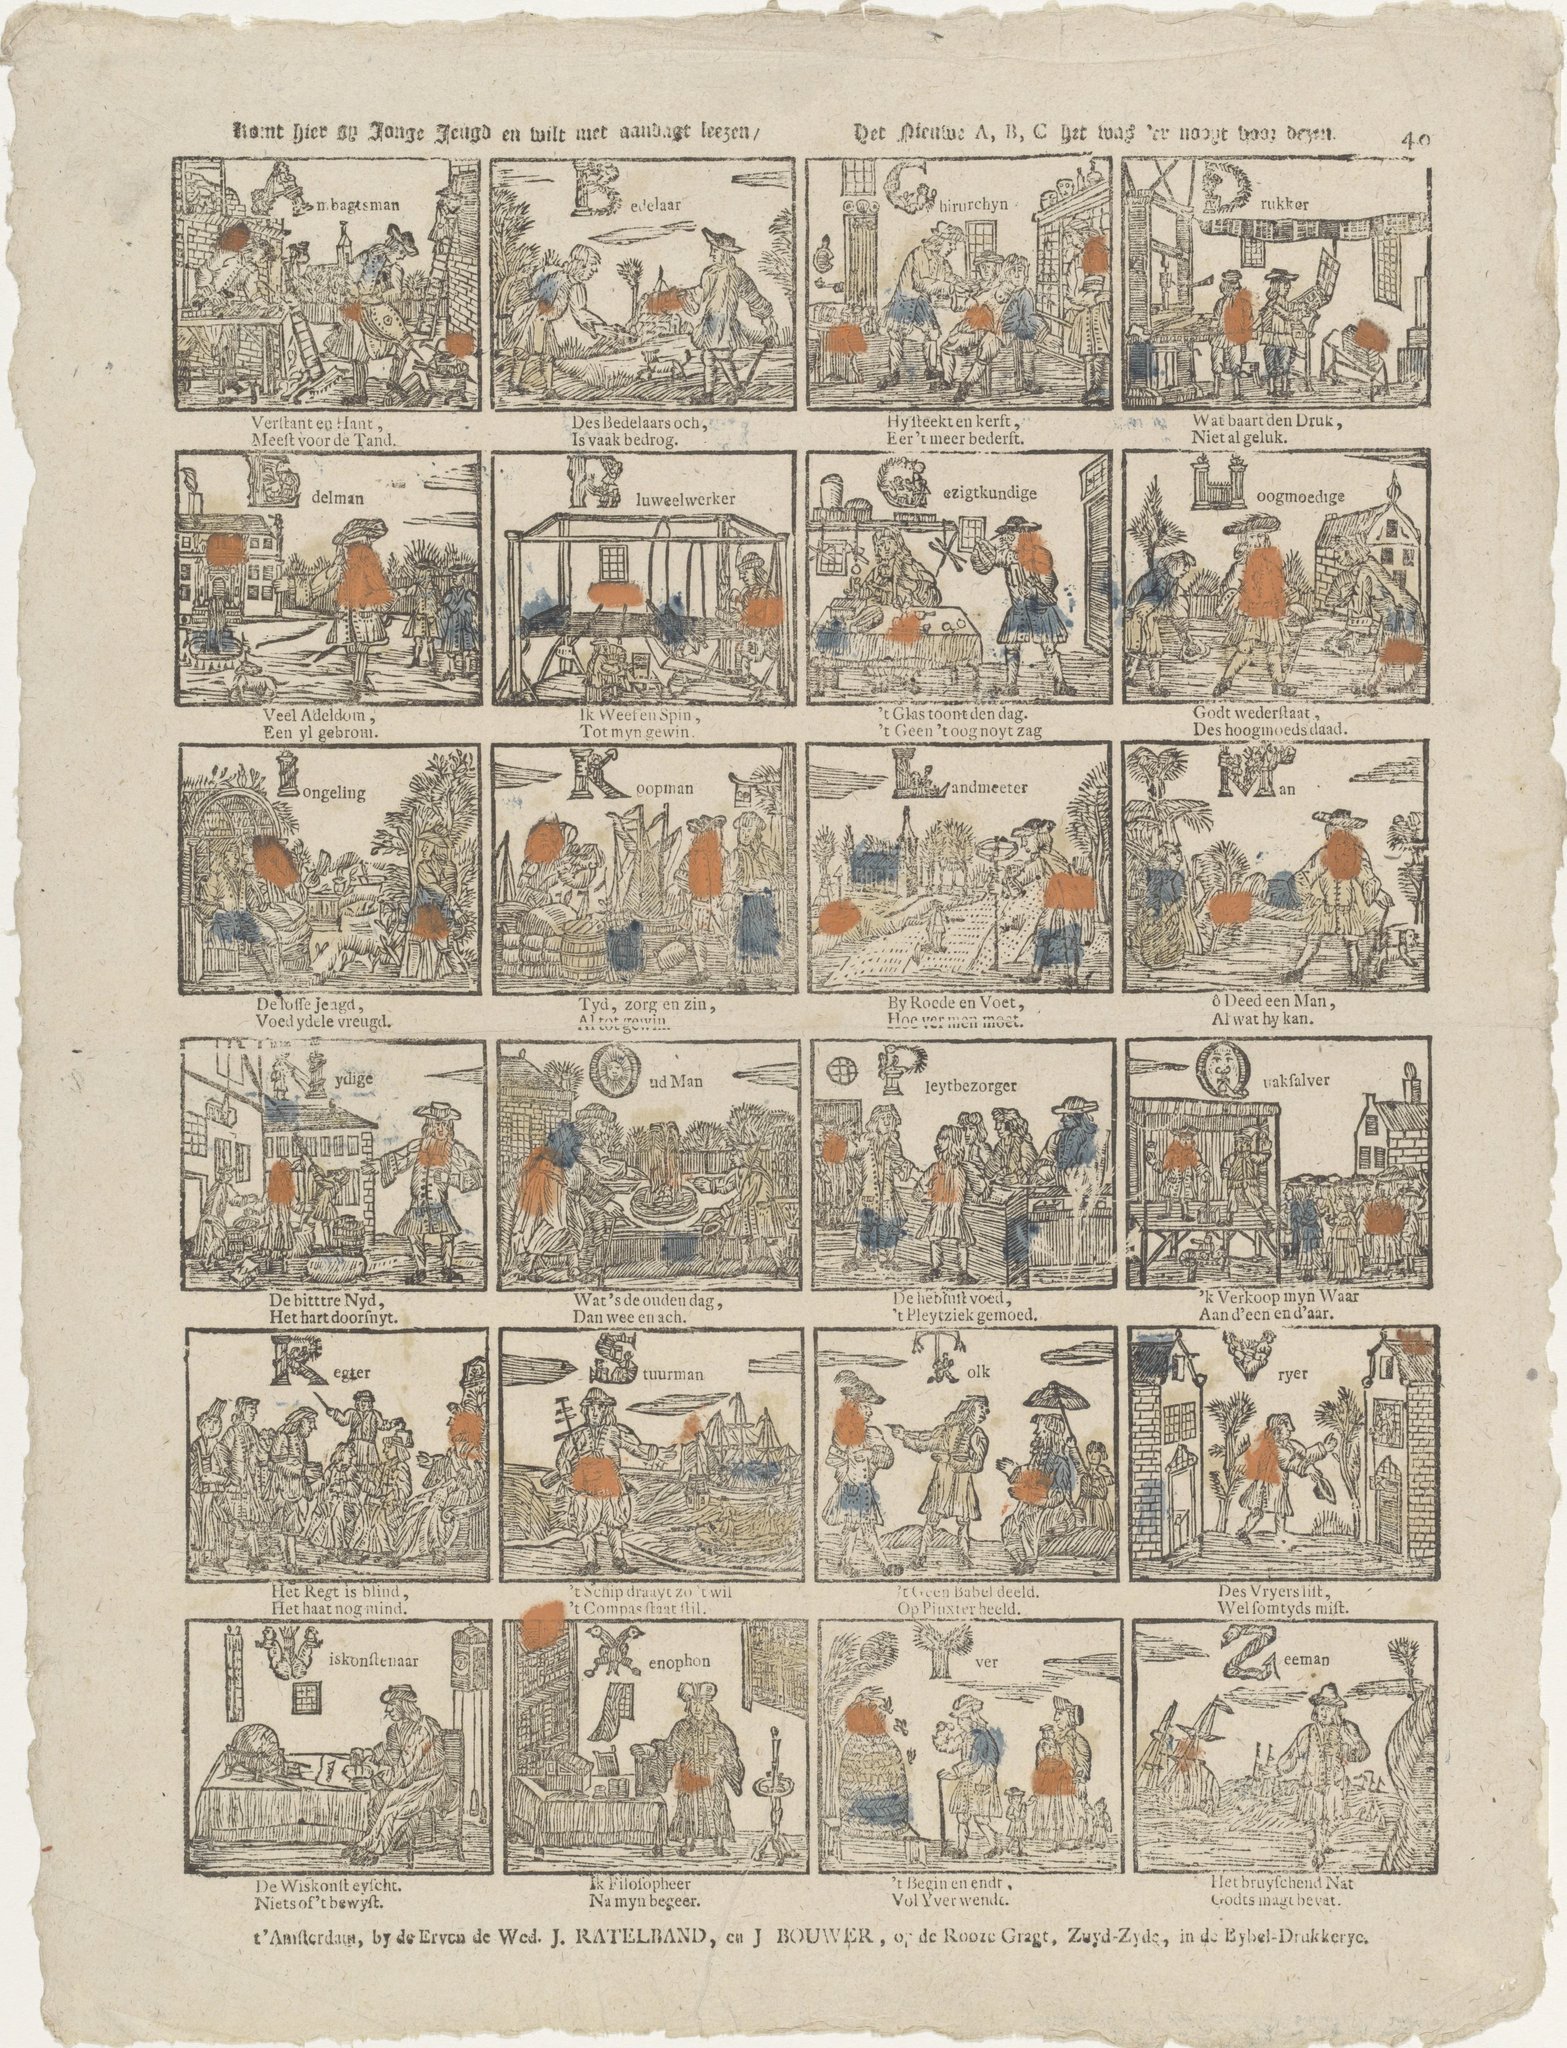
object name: popular print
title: Komt hier gy jonge jeugd en wilt met aandagt leezen / Het nieuwe A, B, C het was er nooyt voor dezen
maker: Anonymous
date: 1782-1793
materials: paper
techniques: colour, letterpress printing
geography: amsterdam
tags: letters, alphabet, script, working class, labourers, crafts and industries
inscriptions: collector's mark: Lugt 2760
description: Blad met 24 voorstellingen van de letters van het alfabet geïllustreerd met beroepen waarvan de woorden met de betreffende letter beginnen. Onder elke voorstelling een onderschrift. Genummerd rechtsboven: 40.